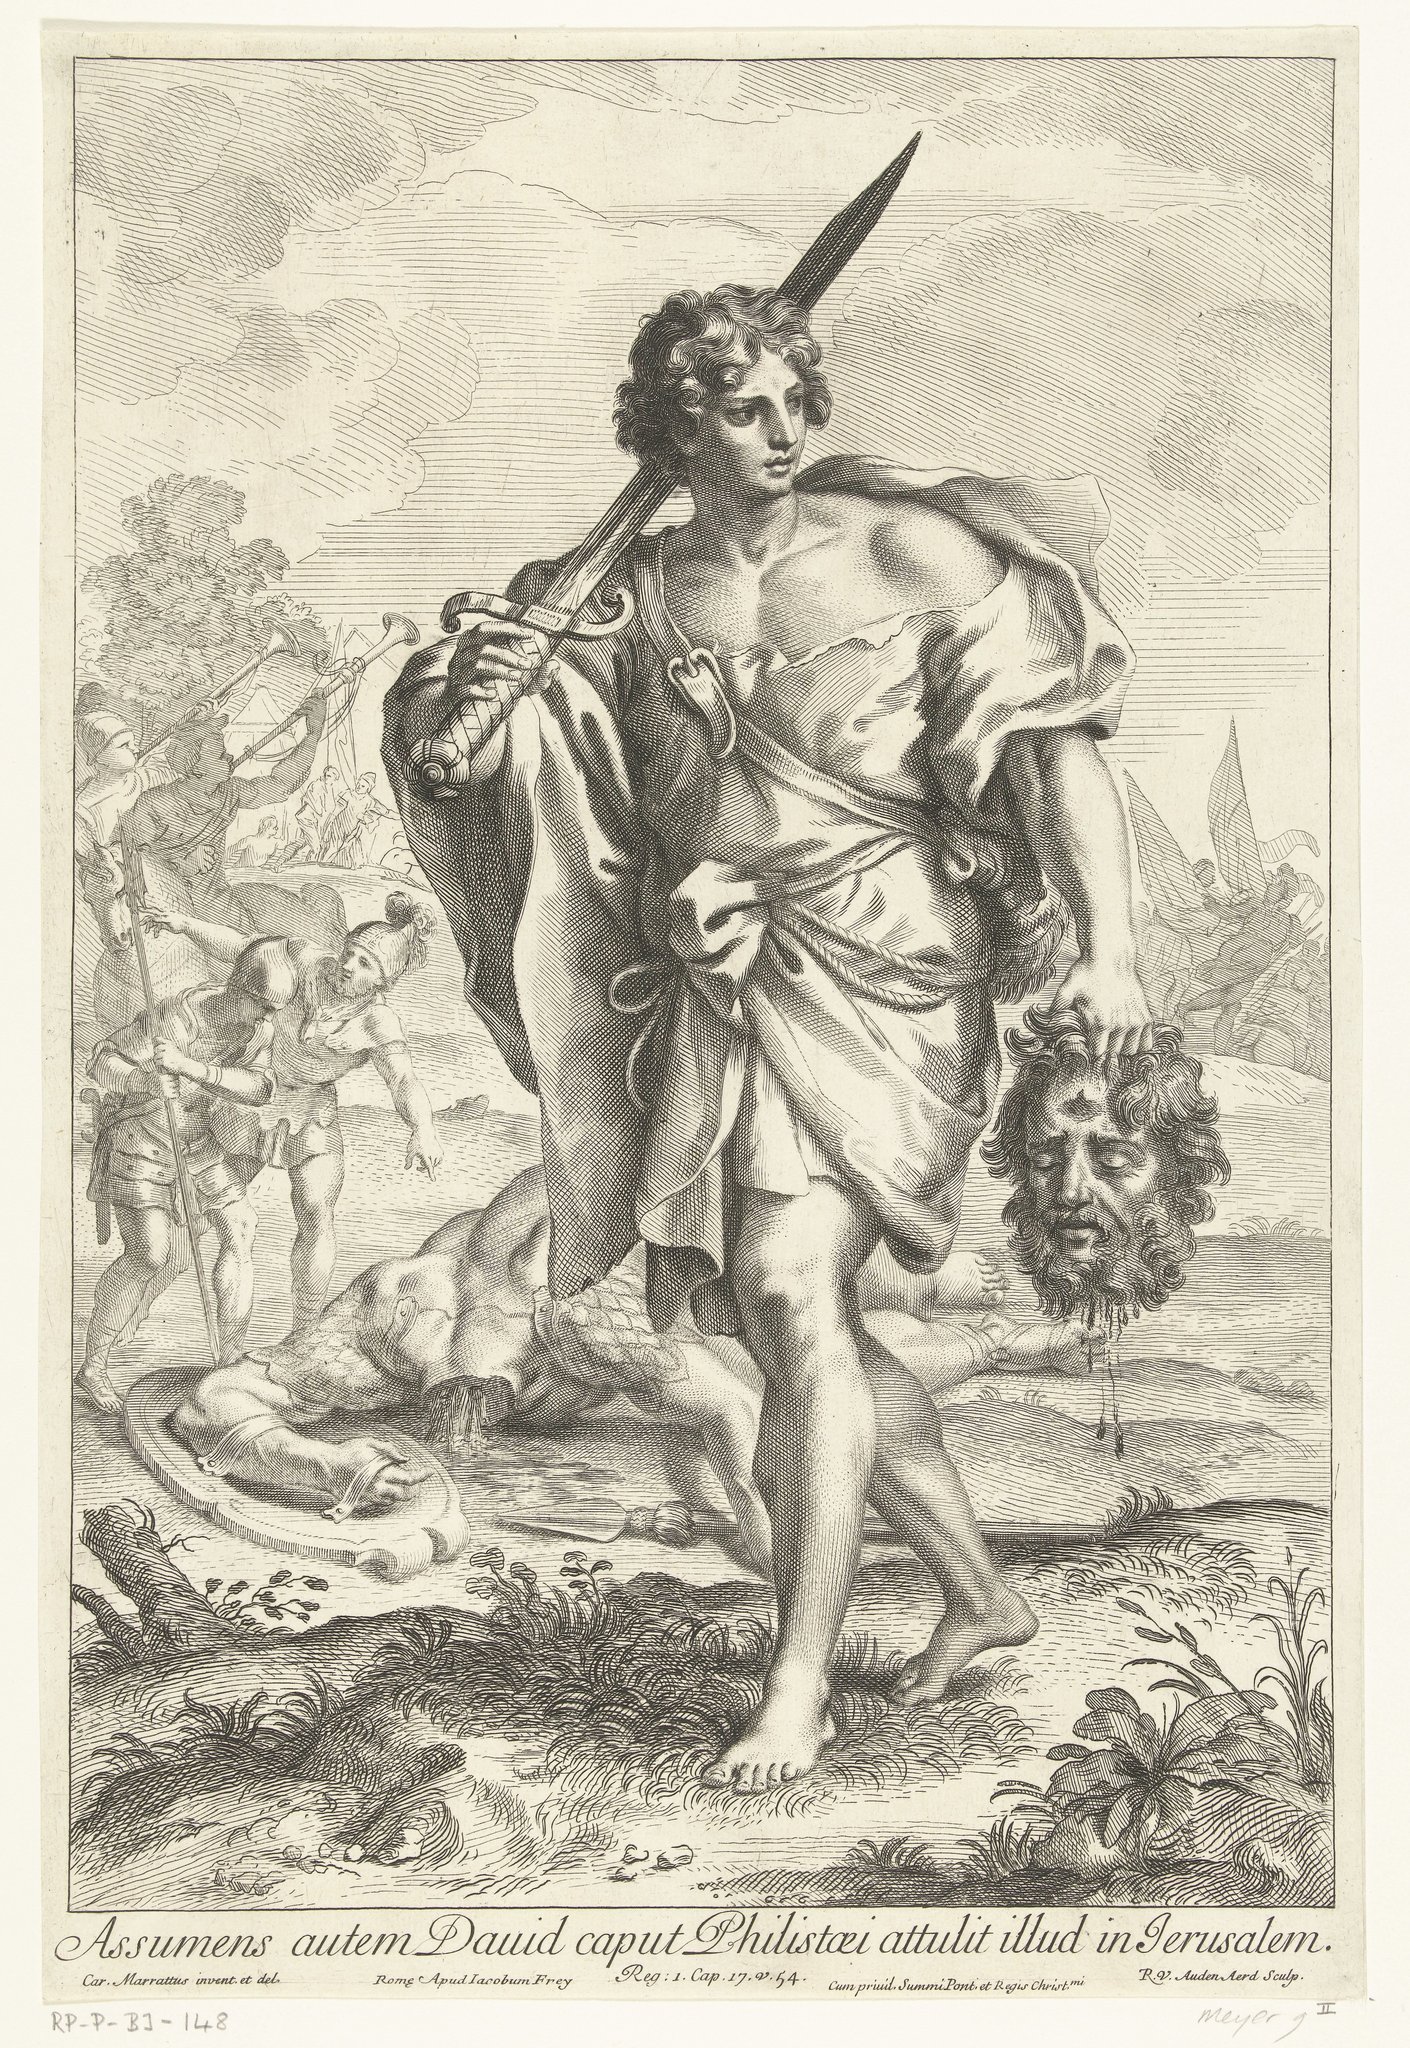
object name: print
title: David met het hoofd van Goliath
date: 1685-1723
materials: paper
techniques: engraving, etching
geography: rome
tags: david with goliath's head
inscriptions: collector's mark: Lugt 2228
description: David met zwaard en het hoofd van Goliath in zijn hand. Achter hem ligt de onthoofde Goliath op de grond omringd door soldaten. In de ondermarge een bijbelvers in het Latijn.